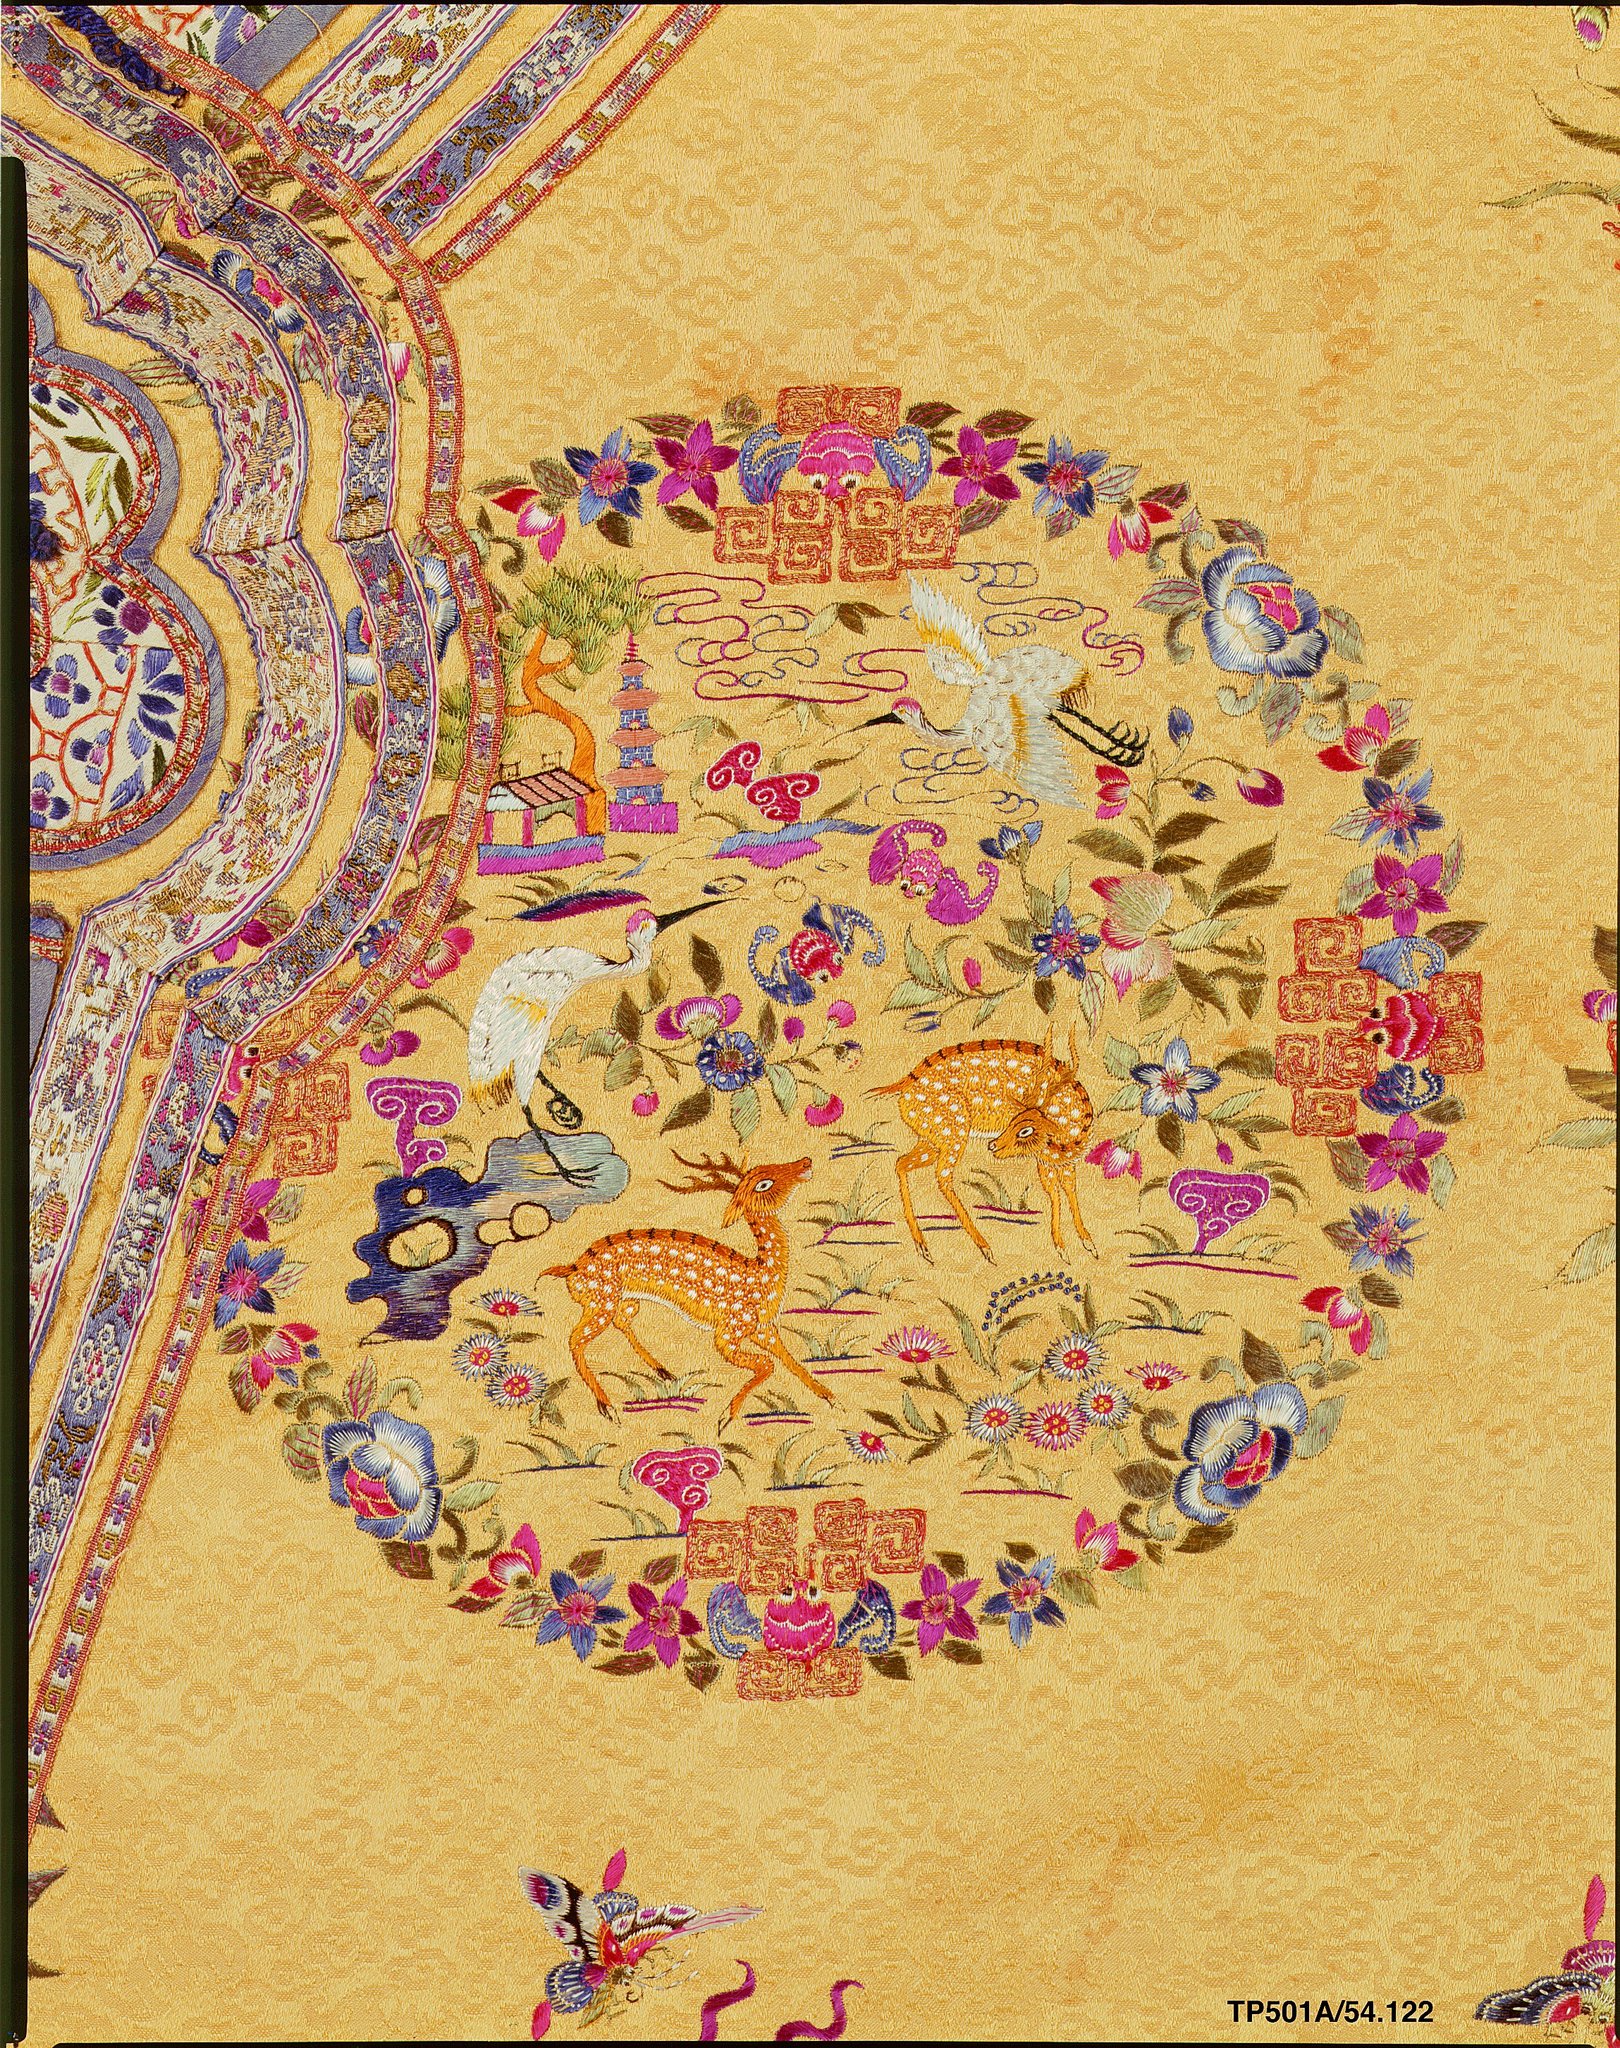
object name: woman's jacket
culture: chinese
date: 1867-1900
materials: silk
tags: cranes,deer